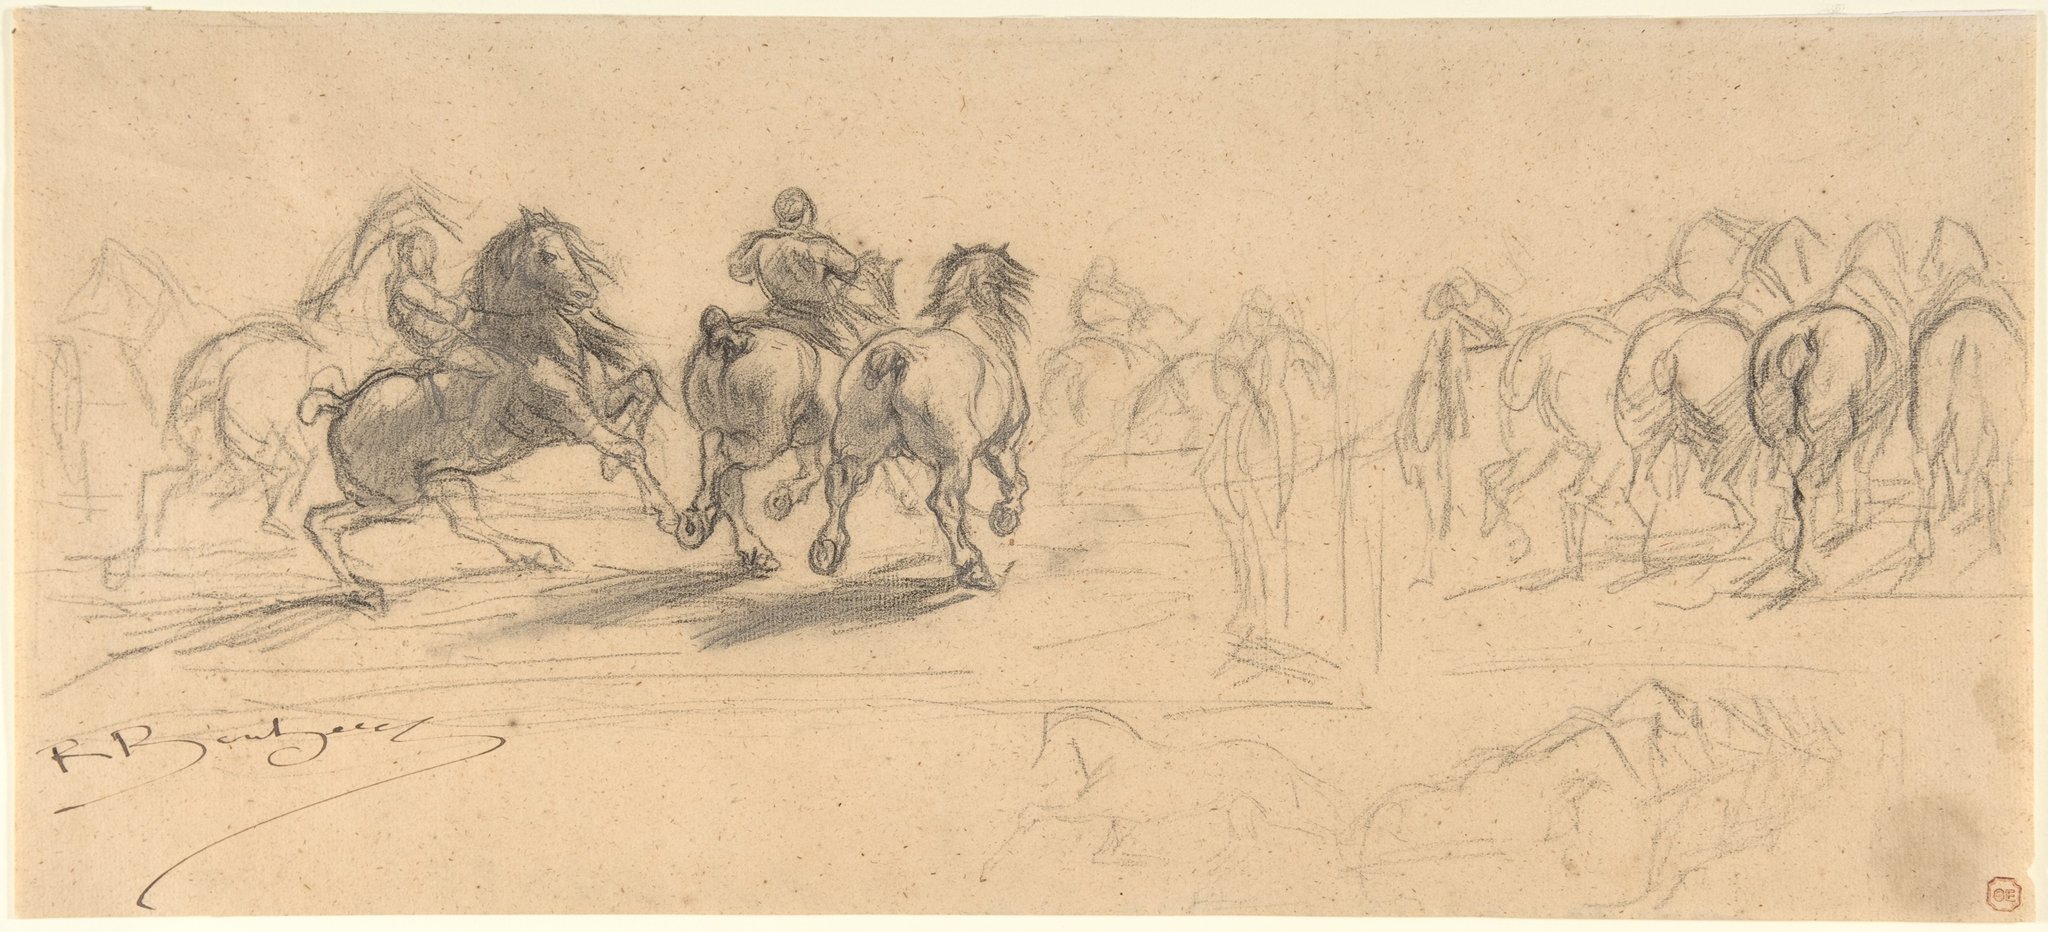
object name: drawing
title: Sheet of Studies for "The Horse Fair"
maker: rosa bonheur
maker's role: artist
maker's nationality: french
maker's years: 1822-1899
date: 1840-1899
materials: chalk, graphite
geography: france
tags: horses